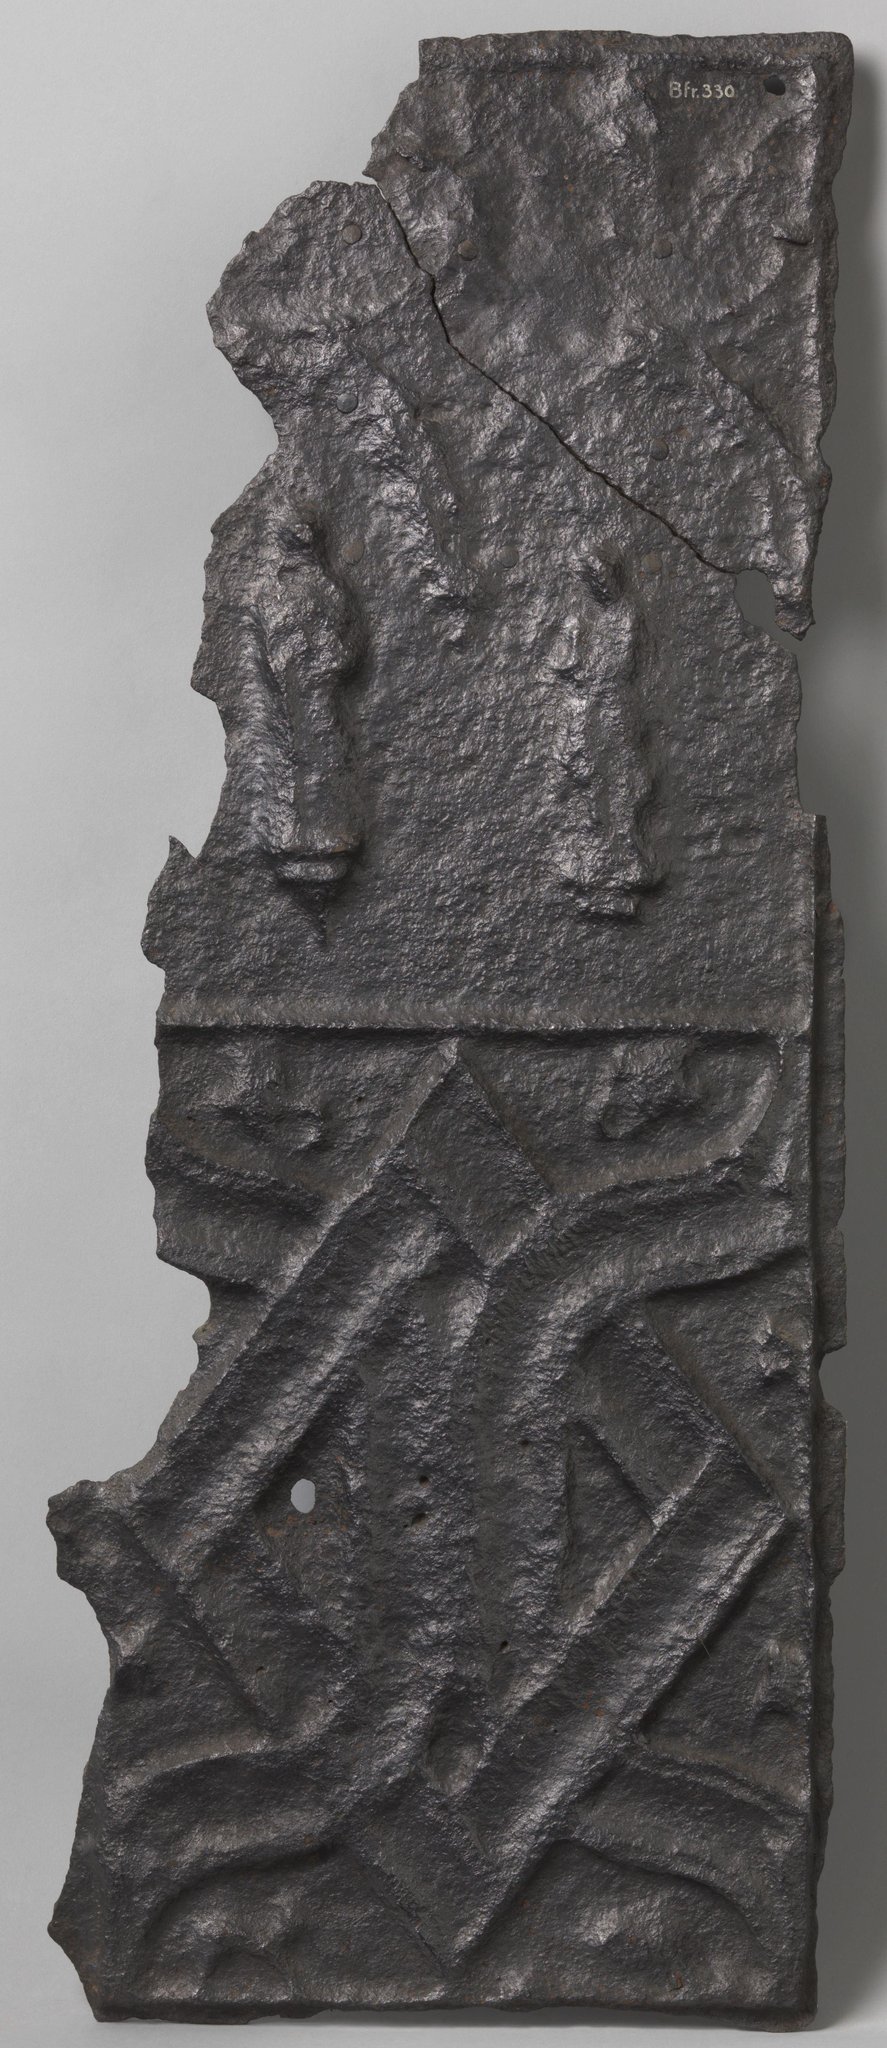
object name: stove plate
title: Kachelplaat met vrouwelijke heiligen en geometrisch patroon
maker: Anonymous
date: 1500-1550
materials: iron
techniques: casting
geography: germany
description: Kachelplaat van gietijzer, verdeeld in twee zones. In de bovenste zone zijn twee vrouwelijke heiligen op een console afgebeeld. In de onderste zone is een geometrisch patroon, van golvende banden temidden van een ruitvorm. Een flink deel van de linkerzijde is verloren gegaan.